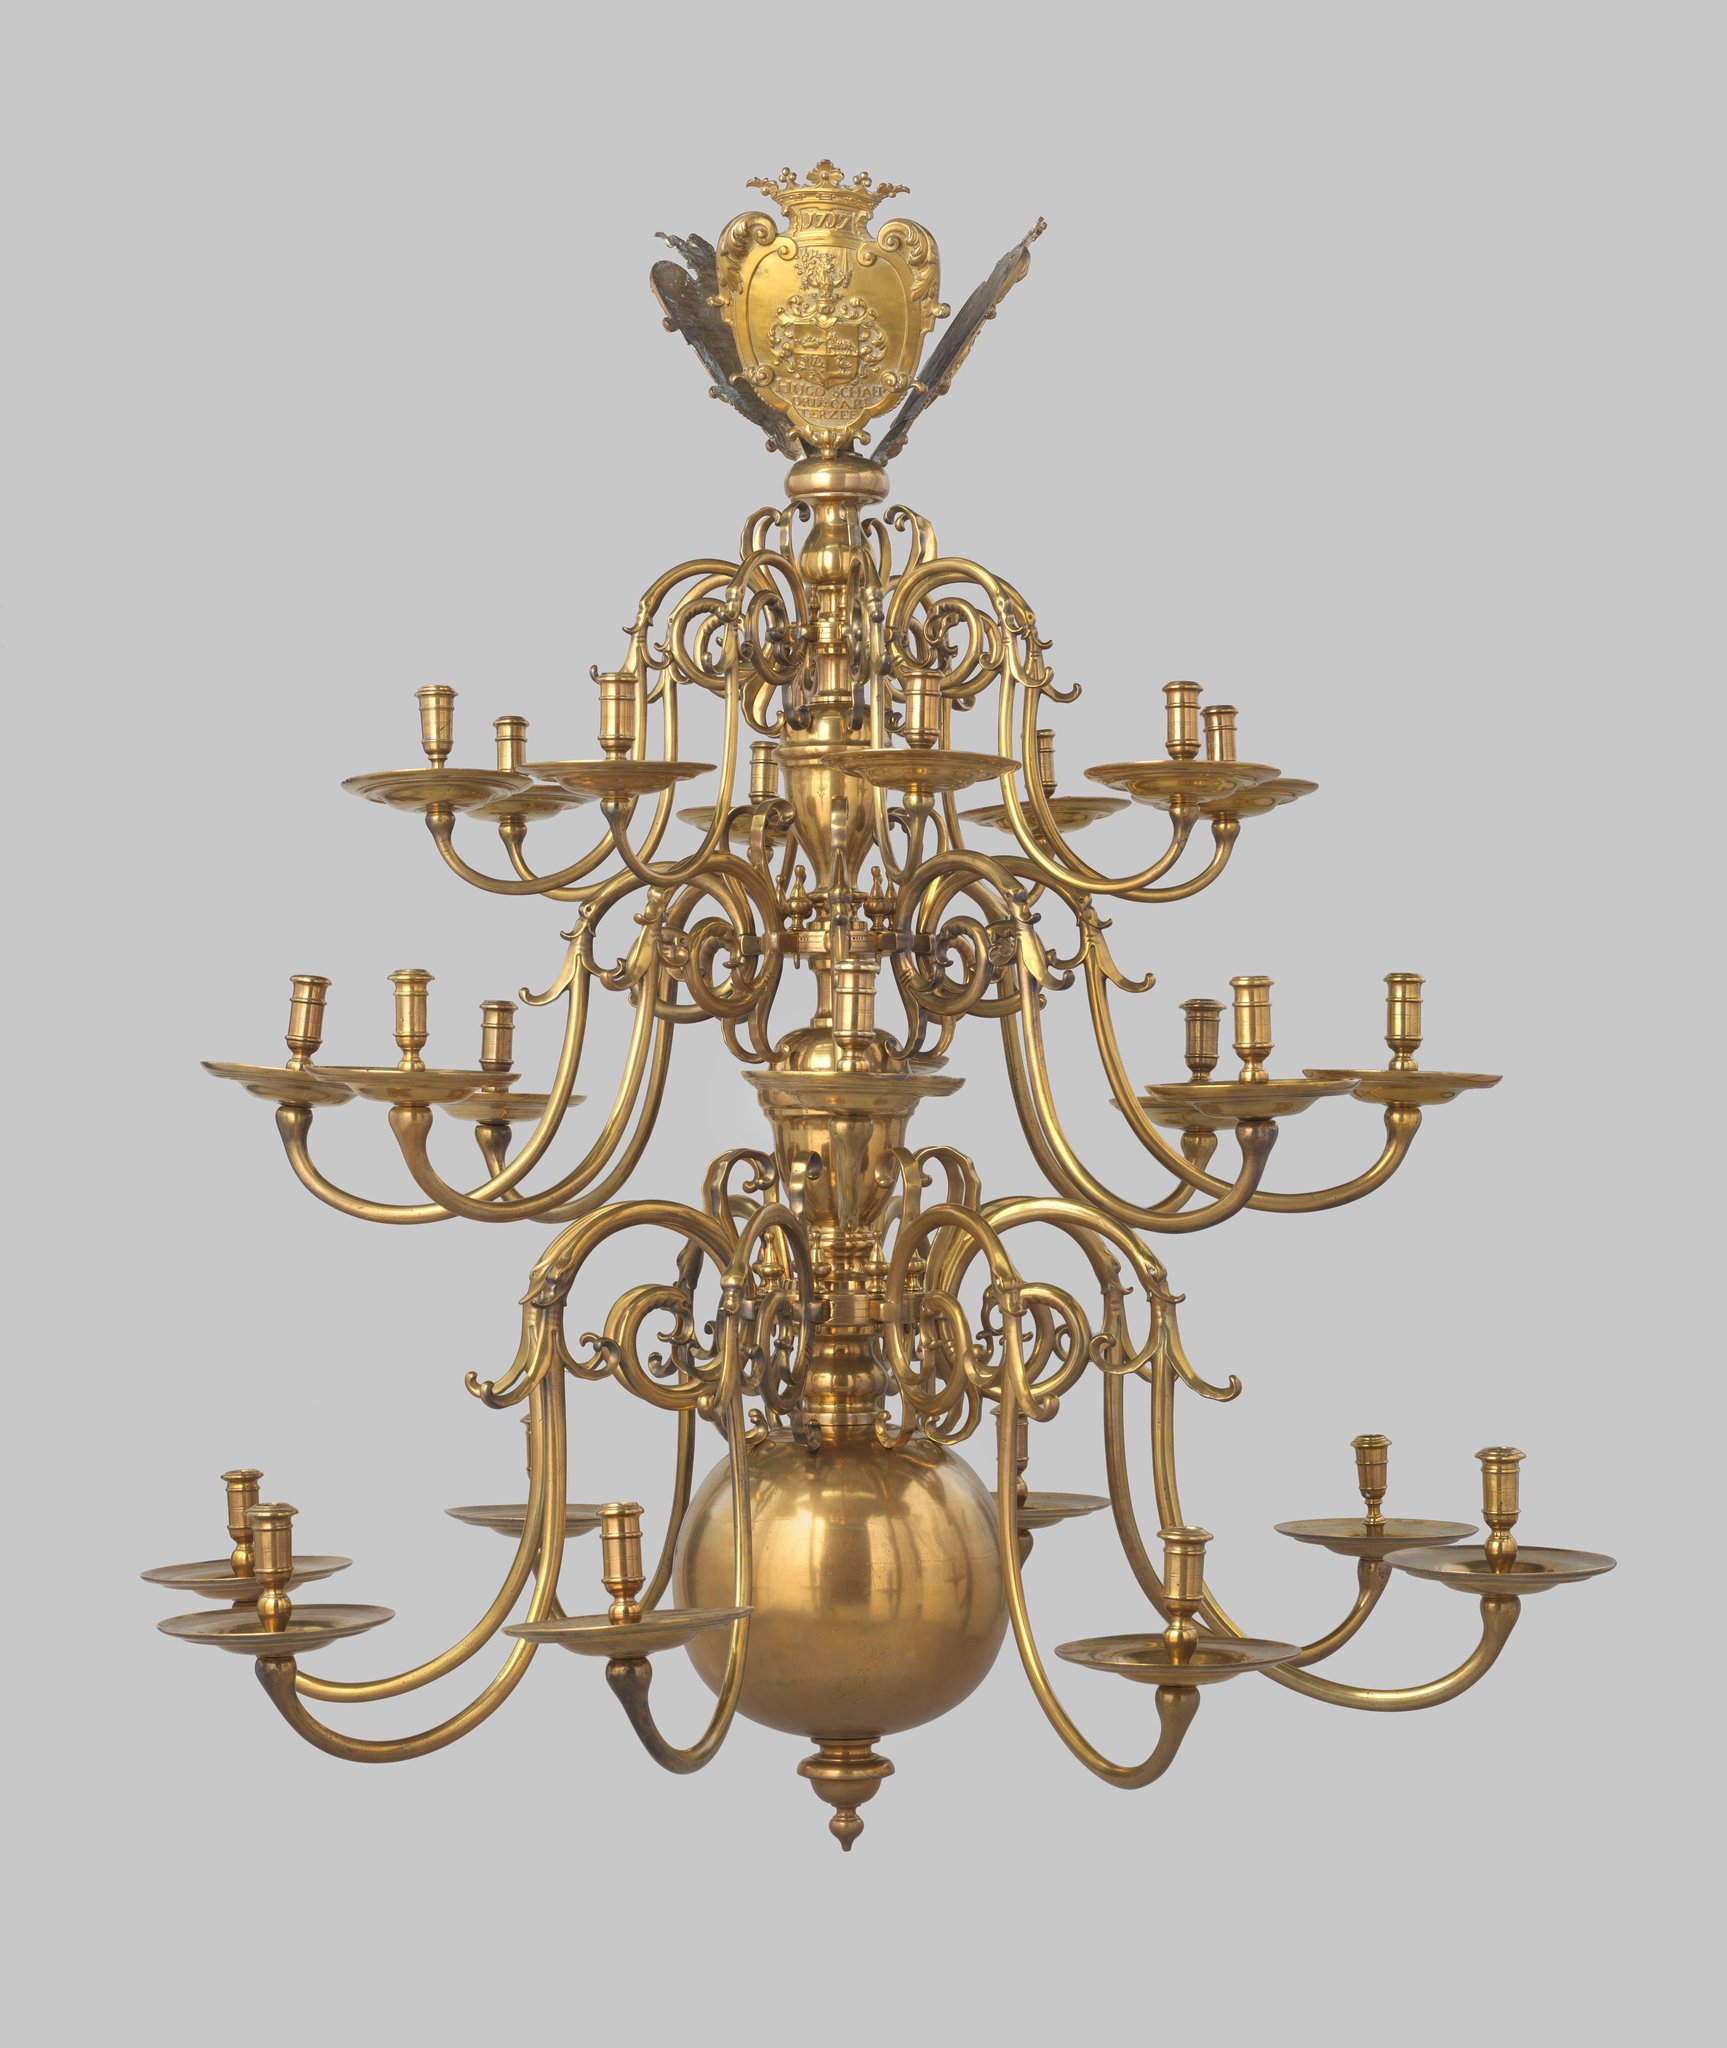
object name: chandelier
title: Arm van een kaarsenkroon in drie hoogten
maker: Anonymous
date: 1717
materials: brass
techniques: casting, screwed, turning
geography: amsterdam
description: De S-vormige arm is aan de stamzijde voorzien van een nok om deze met een pin in de standring te kunnen vastzetten. Bij de stam is de arm op het eind en naar het midden toe versierd met twee gestileerde dolfijnenkoppen en met krullen, waarvan de vorm aan het kwabornament is ontleend. Naar buiten toe eindigt de arm in een verdikking, waarin een van een schroefdraad voorzien gat is aangebracht ter bevestiging van de kaarsenhouder op de vetvanger. De arm is met behulp van hetzelfde model gegoten als de overige armen van de krans. De kaarsenhouder is cylindervormig met geprofileerd uitstekende rand en met een balustervoet, welke overgaat in een van een schroefdraad voorzien eind, waarin onderaan het centergat. De vetvanger is aan de bovenkant naar het midden toe twee keer verdiept. Aan de onderkant is deze rond het gat in het enigszins bolvormige midden geprofileerd en is de rand geribd. De vetvanger met behulp van hetzelfde model gegoten als de overige vetvangers van deze krans. De pin is voorzien van een vaasvormige knop. Dit is de vijfde arm van de bovenste standring, genummerd op de nok met het cijfer V.